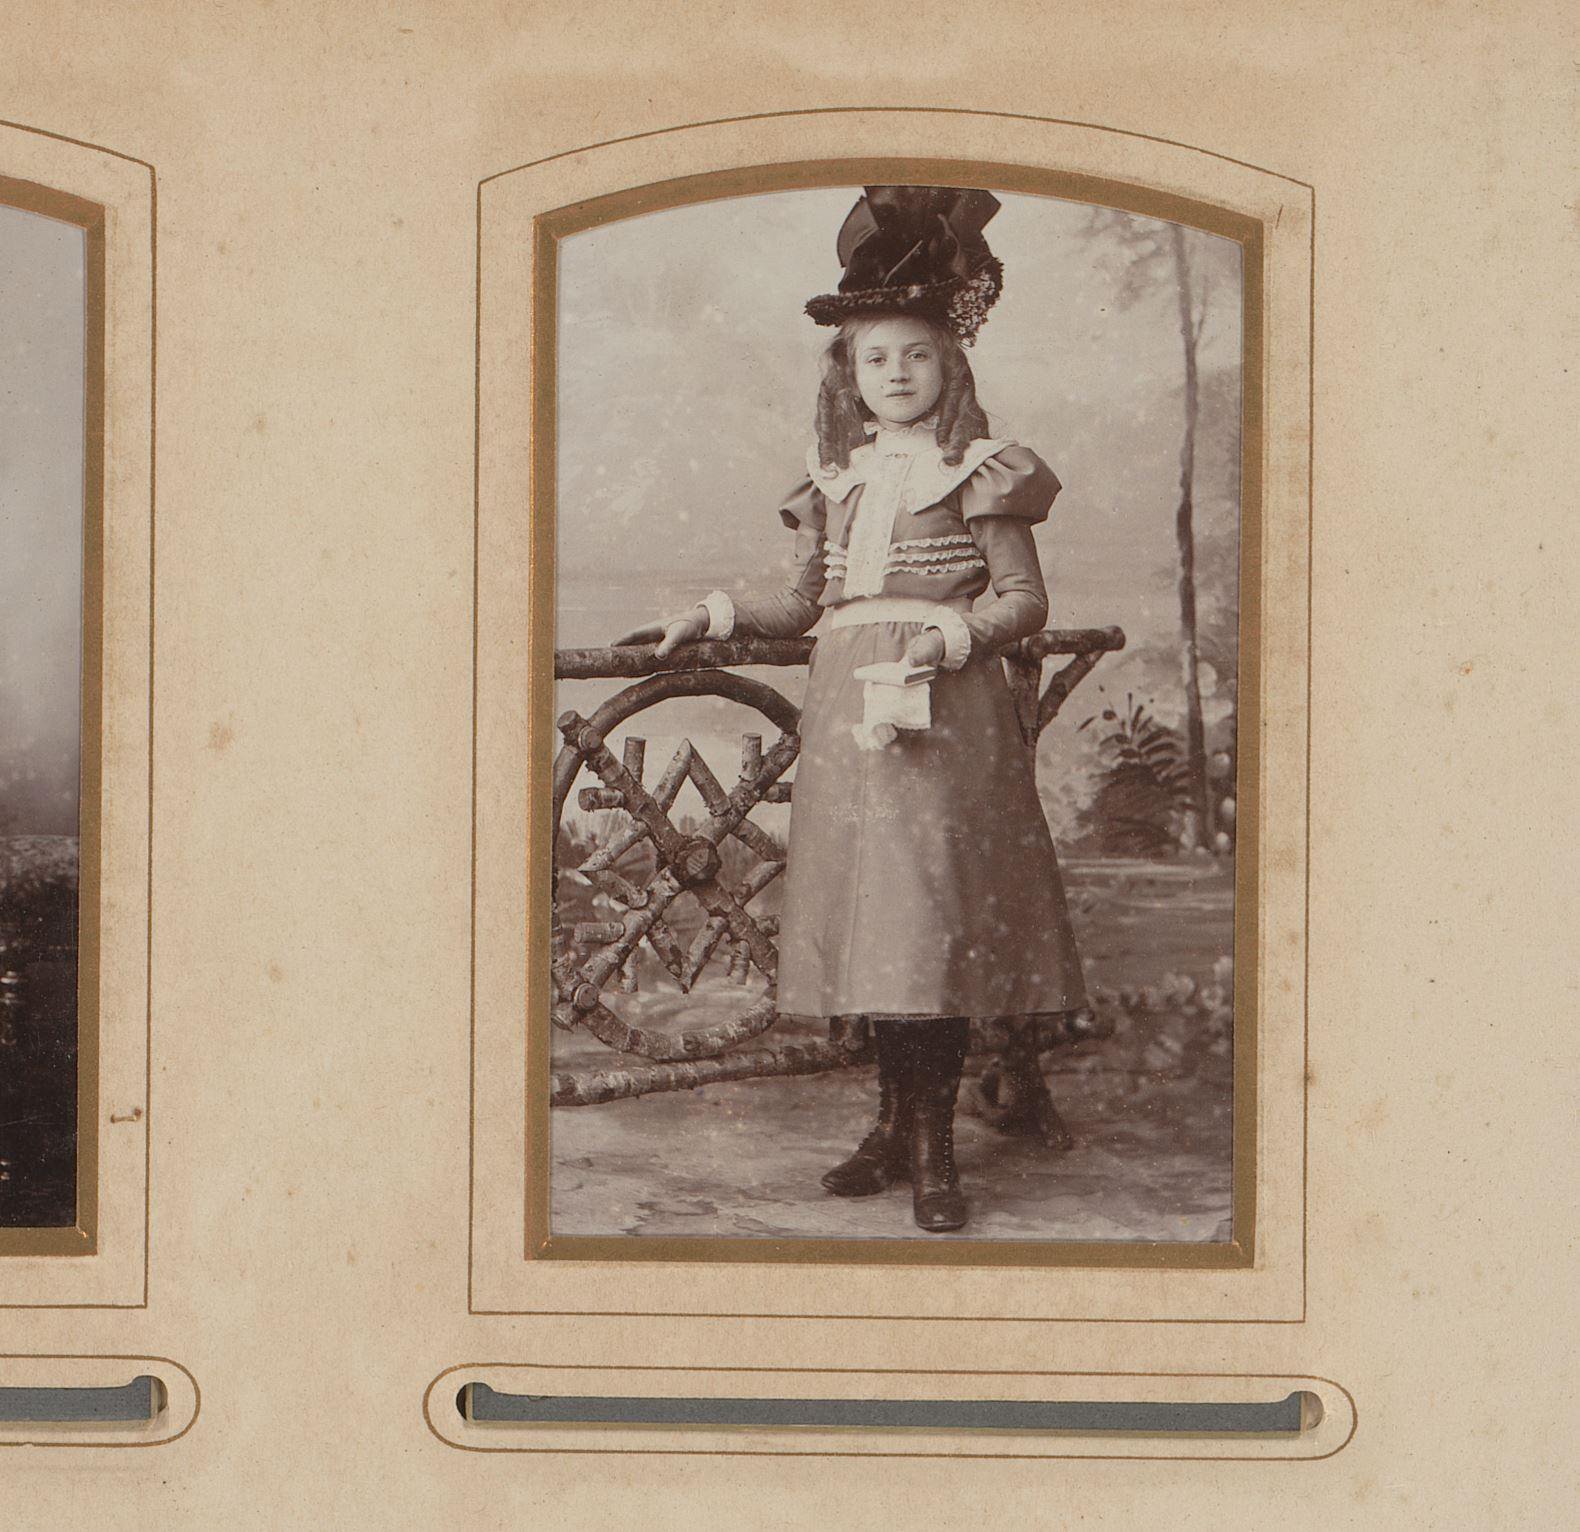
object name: album leaf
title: Portret van een staand meisje met hoed en een boek in de hand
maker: gustave narcisse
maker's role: fotograaf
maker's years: 1857-1920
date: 1892-1909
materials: cardboard, photographic support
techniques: collodion silver print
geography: brussels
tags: historical persons - bb - woman, girl (child between toddler and youth), head-gear: hat, book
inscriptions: inscription: ‘Gve Narcisse/ PHOTOGRAPHIE/ DE L'EPOQUE./ 12 Rue de L'Empereur/ Bruxelles./ Les Clichés sont conservés.’